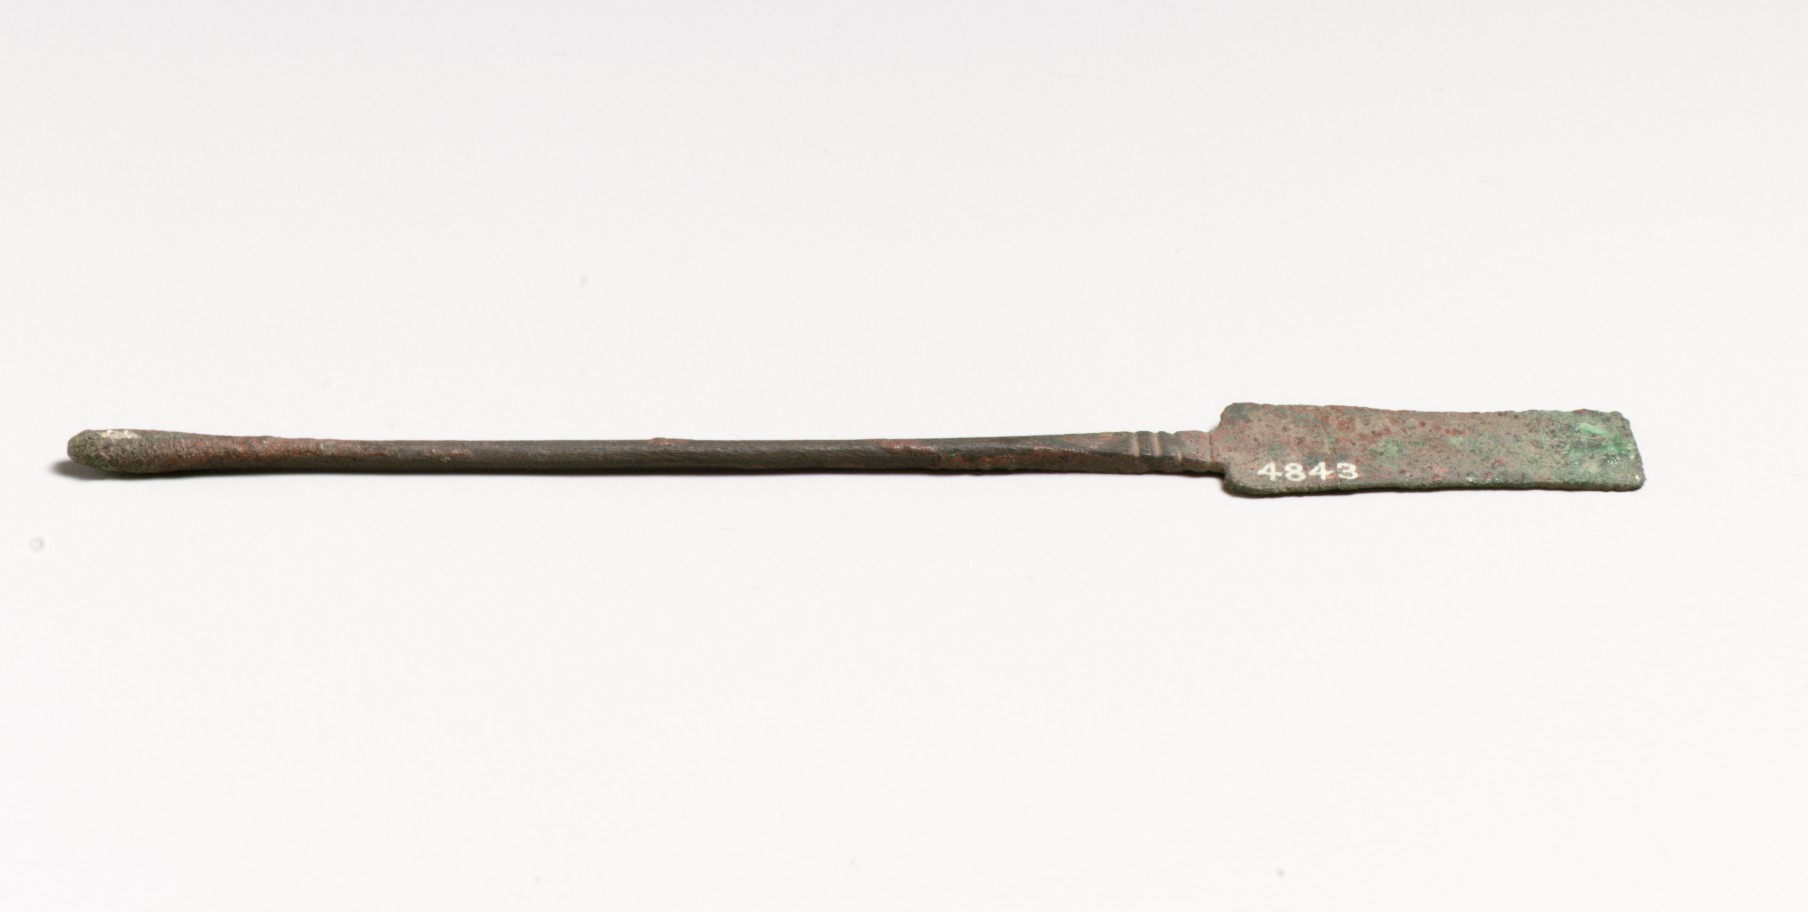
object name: spatula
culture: cypriot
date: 3900 BCE-100 CE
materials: bronze